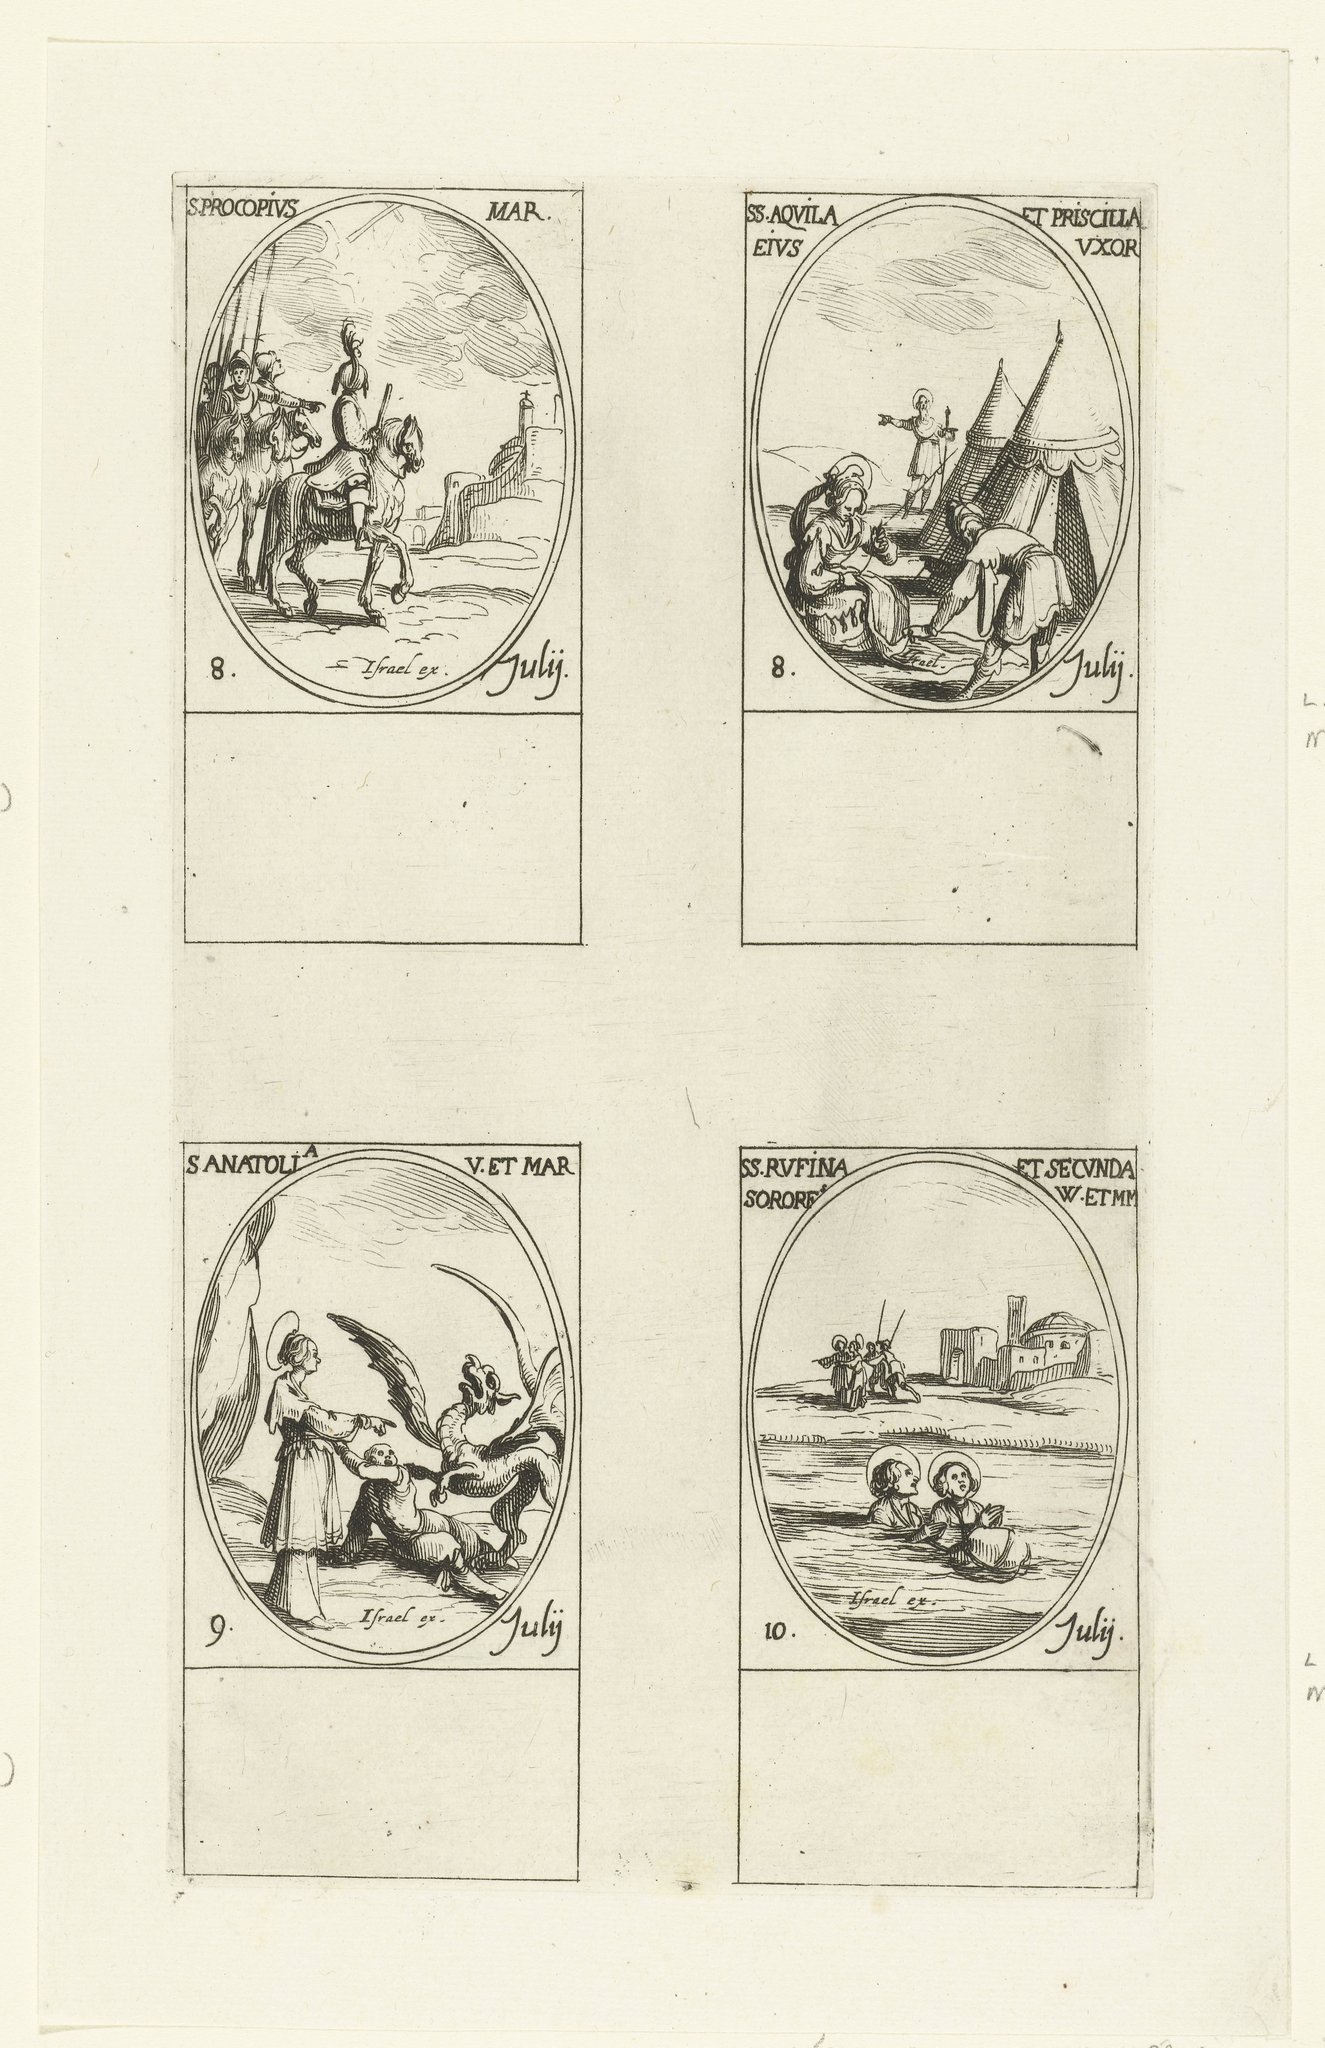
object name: print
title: Alle heiligen en de Christelijke feestdagen van het jaar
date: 1632-1636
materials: paper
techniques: etching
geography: paris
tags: female saints (with name), paul in the workshop of aquila and priscilla, who may be shown weaving and spinning, male saints (with name)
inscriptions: collector's mark: Lugt 240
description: Blad met vier ovale voorstellingen, elk met opschrift en datum in het Latijn: linksboven de Heilige Procopius als legerleider te paard, rechtsboven de Heilige Aquila met zijn vrouw Priscilla en de Heilige Paulus bij twee tenten, linksonder de Heilige Anatolia die een draak bedwingt, rechtsonder de zusters Rufina en Secunda met een steen aan een touw om hun nek in het water. Deze prent is onderdeel van een serie prenten met voorstellingen van de heiligen en de christelijke feestdagen van het jaar. Er zijn steeds vier scènes van één plaat op één blad gedrukt. Inclusief bijbehorend titelblad en frontispice gaat het in totaal om 124 platen (490 voorstellingen). De drie platen met de laatste 12 scènes (de veranderlijke christelijke feestdagen) zijn in de derde staat versneden tot 12 kleine plaatjes, en met een apart titelblad uitgegeven.